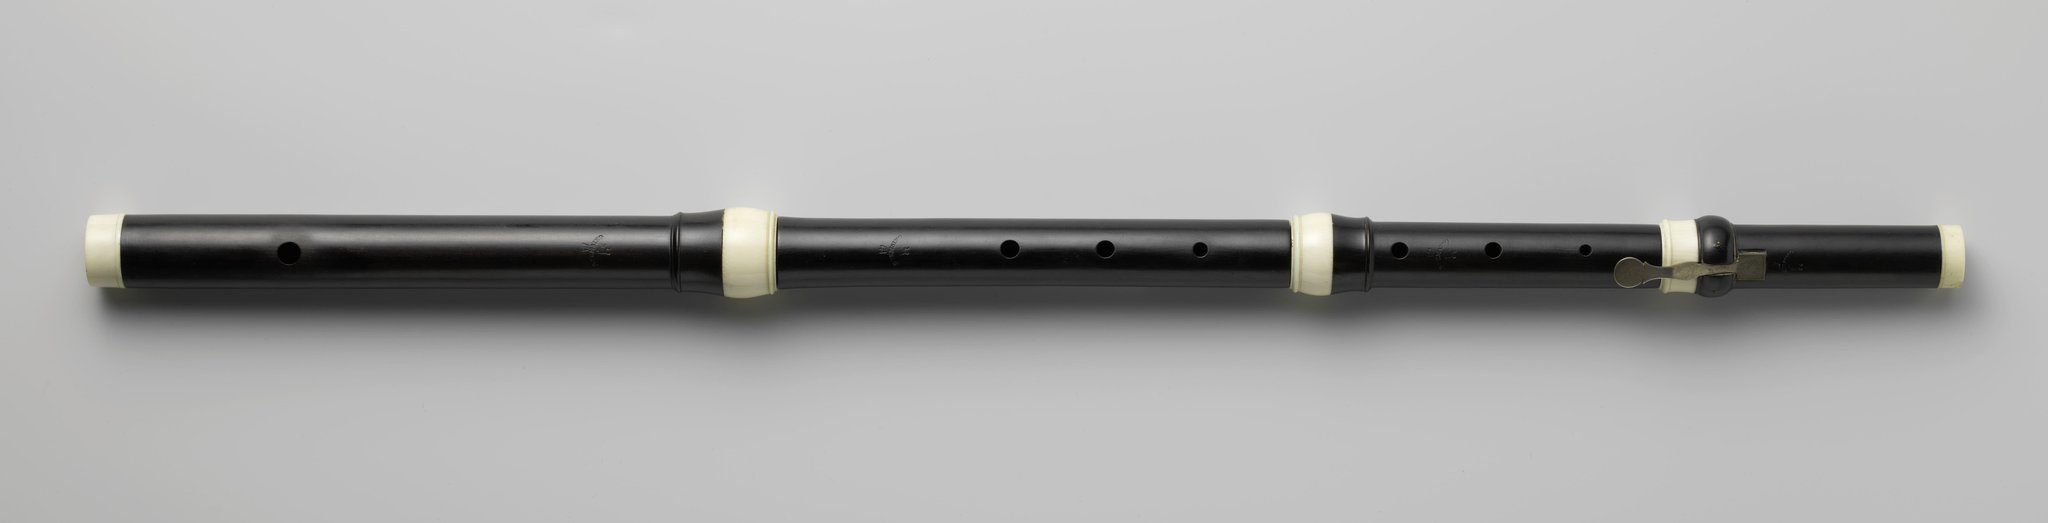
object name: flute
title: Alto flute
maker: bernard hemsing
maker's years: 1703-1776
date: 1730-1750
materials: wood, ivory, silver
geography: leiden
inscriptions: stamp: ‘B:HEMSING’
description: Transverse flutes have existed in various forms since 3000 BC. Around 1720, Amsterdam was a centre for the manufacture of woodwind instruments, including flutes. The earliest, with one key and often made of boxwood, and ebony or ivory, were crafted individually. Alto flutes from that time are rare.